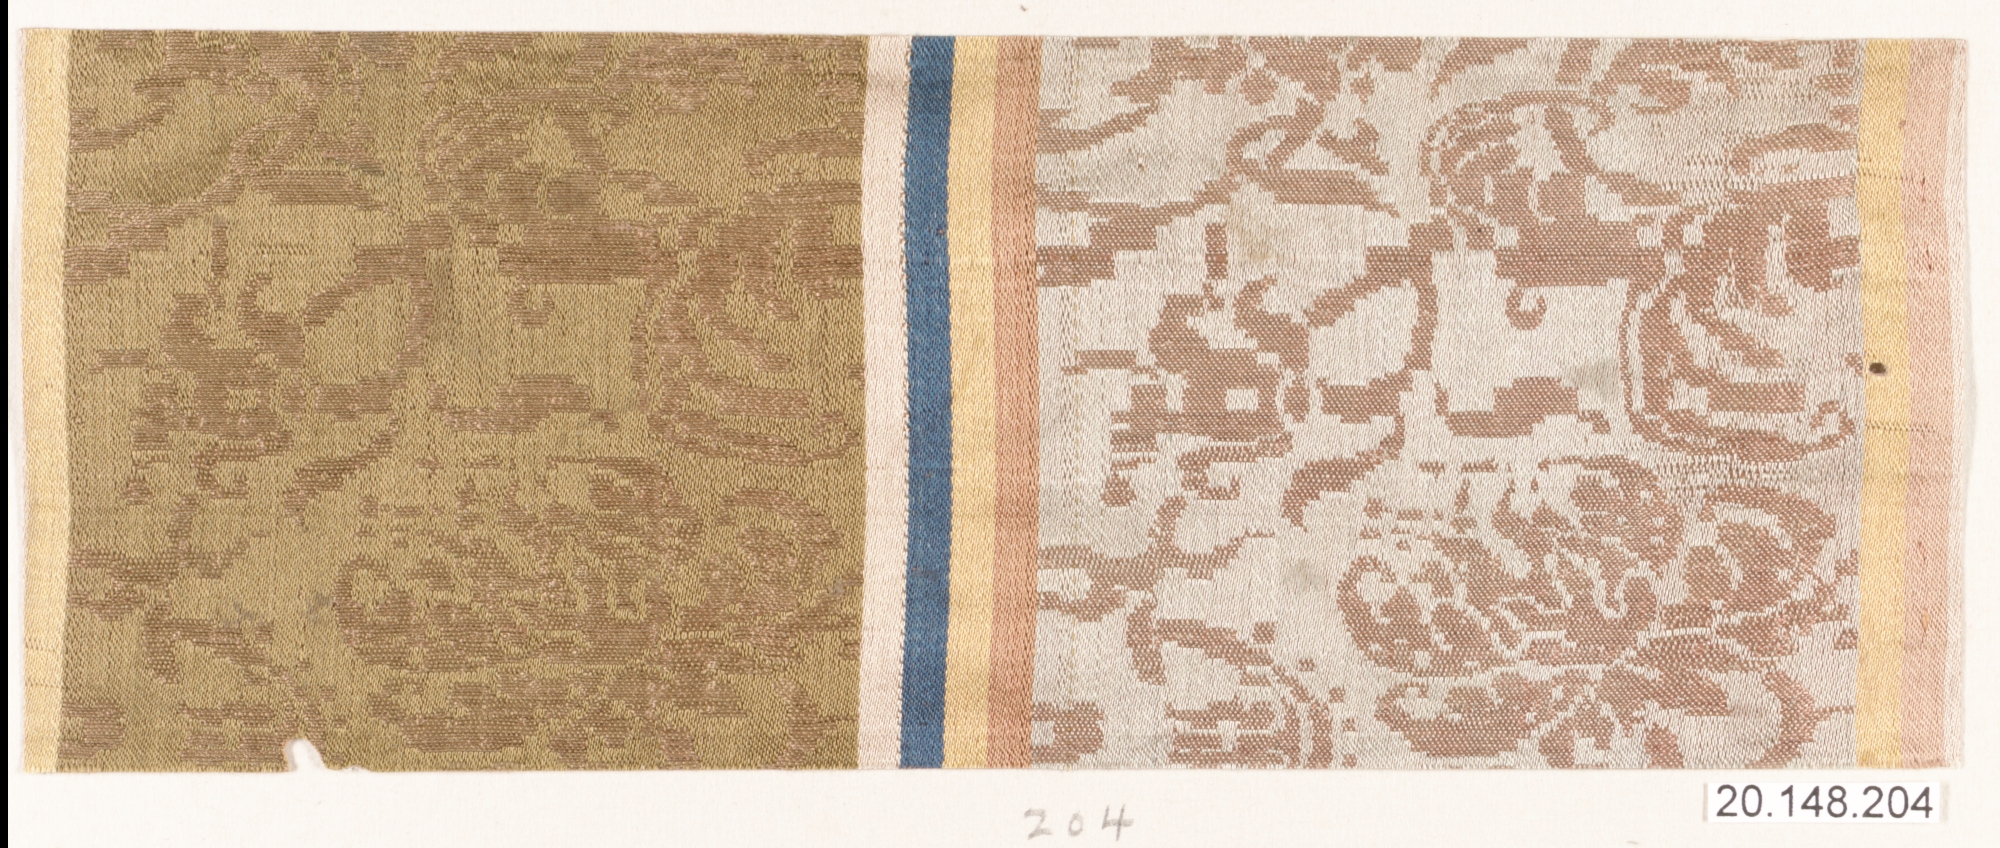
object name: piece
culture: japanese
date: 1701-1800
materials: silk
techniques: compound weave